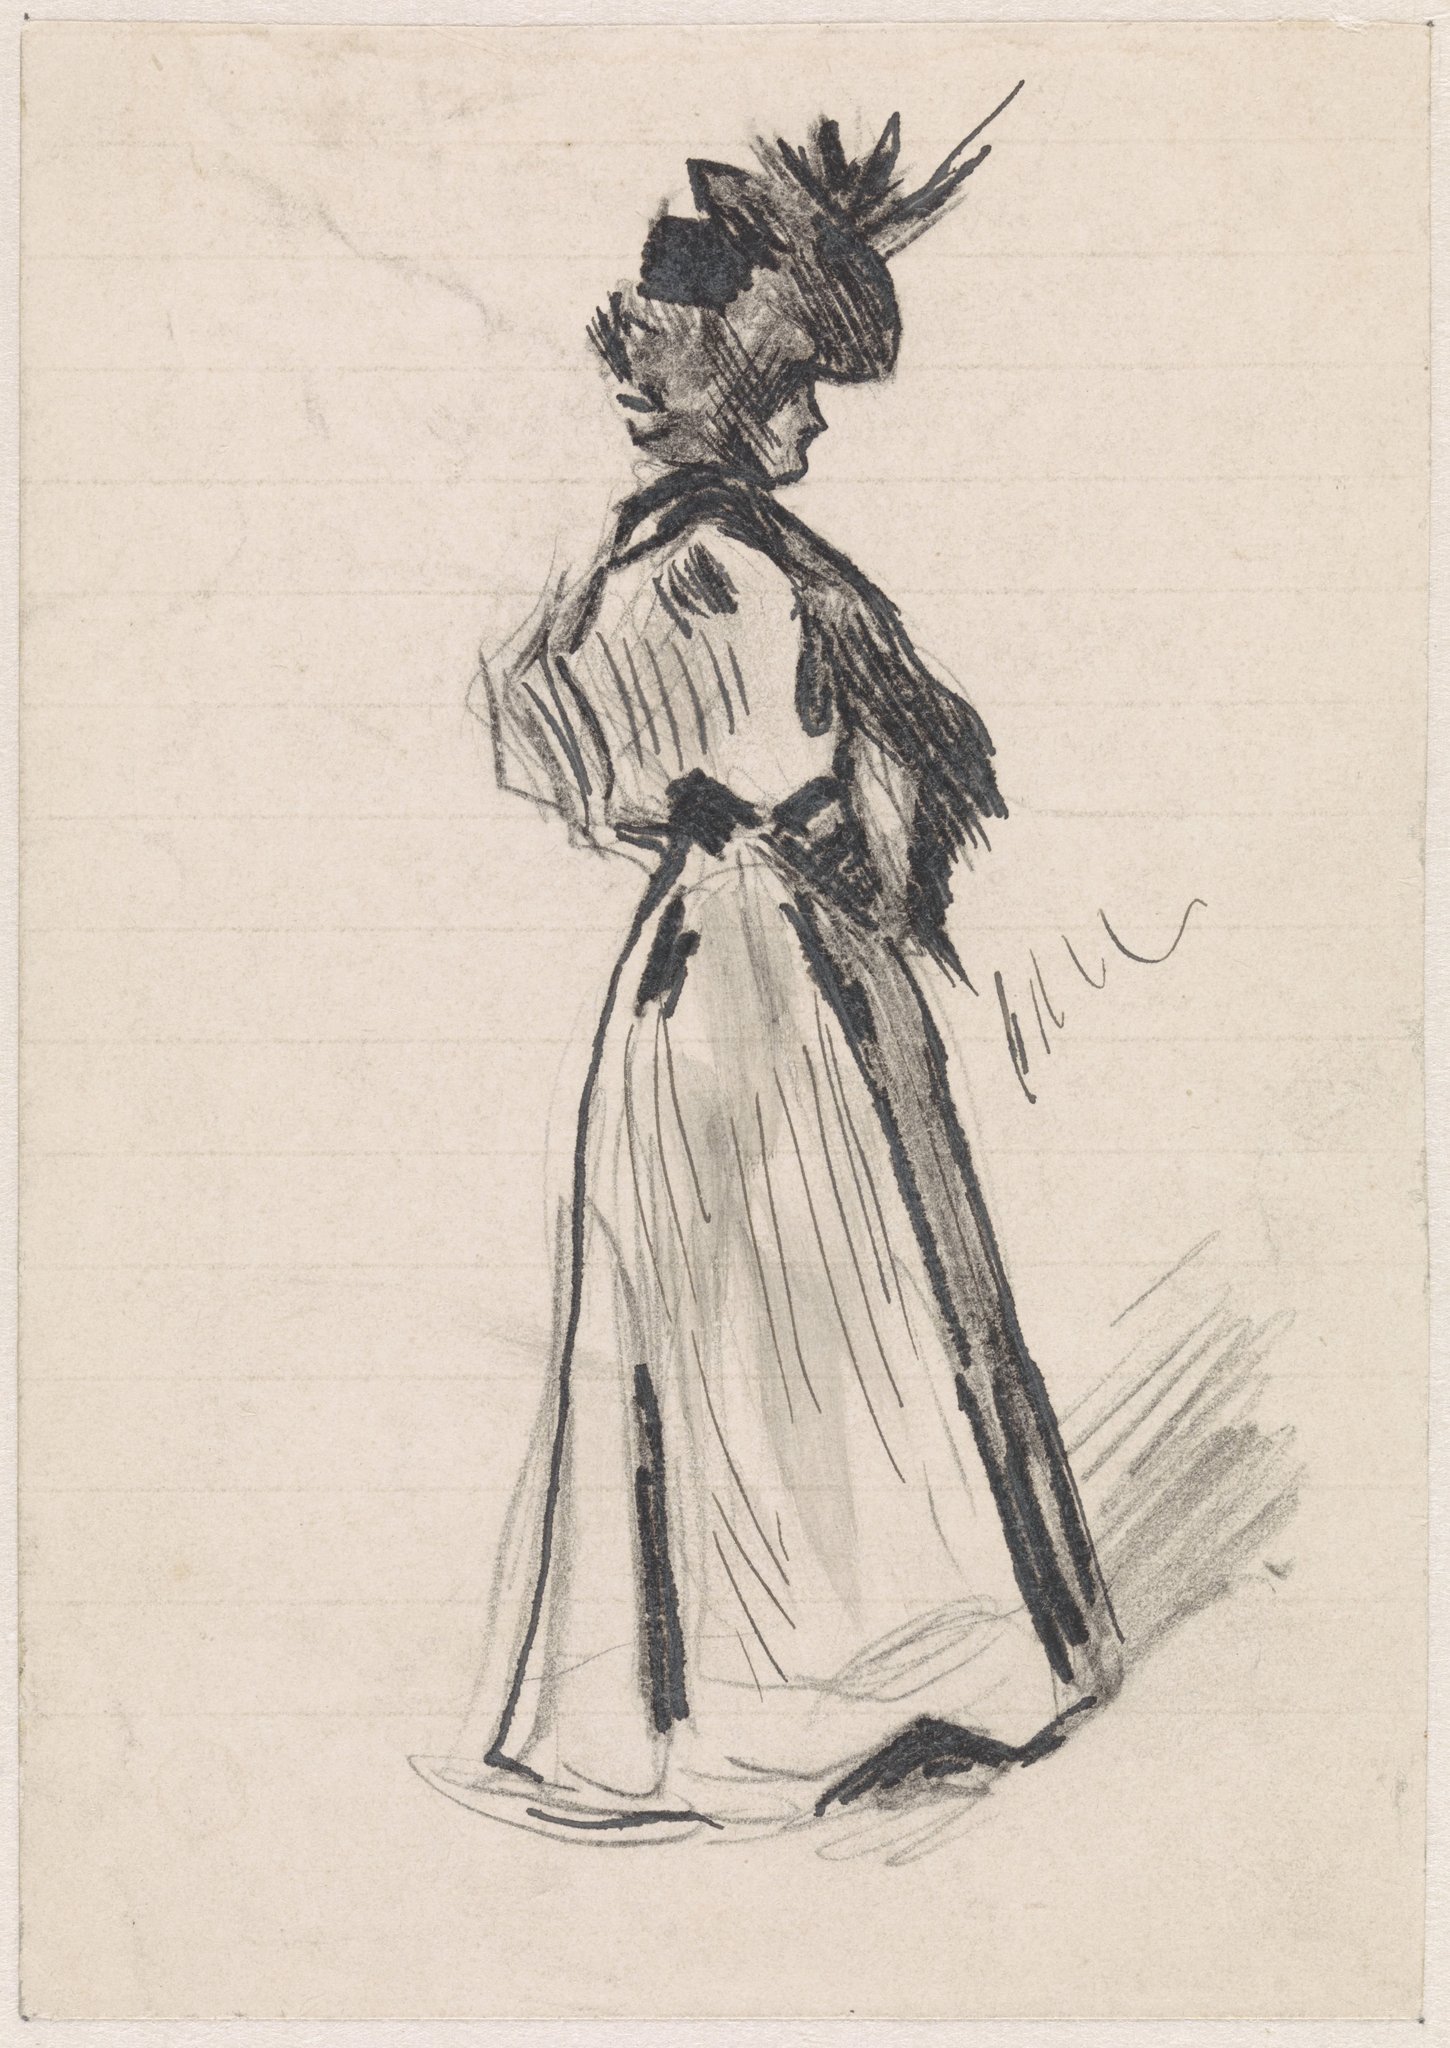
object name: drawing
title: Staande dame, met hoge hoed en de handen in de zij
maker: jan van essen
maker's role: draughtsman, print maker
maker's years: 1854-1936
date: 1864-1936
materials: chalk, ink, paper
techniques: pen